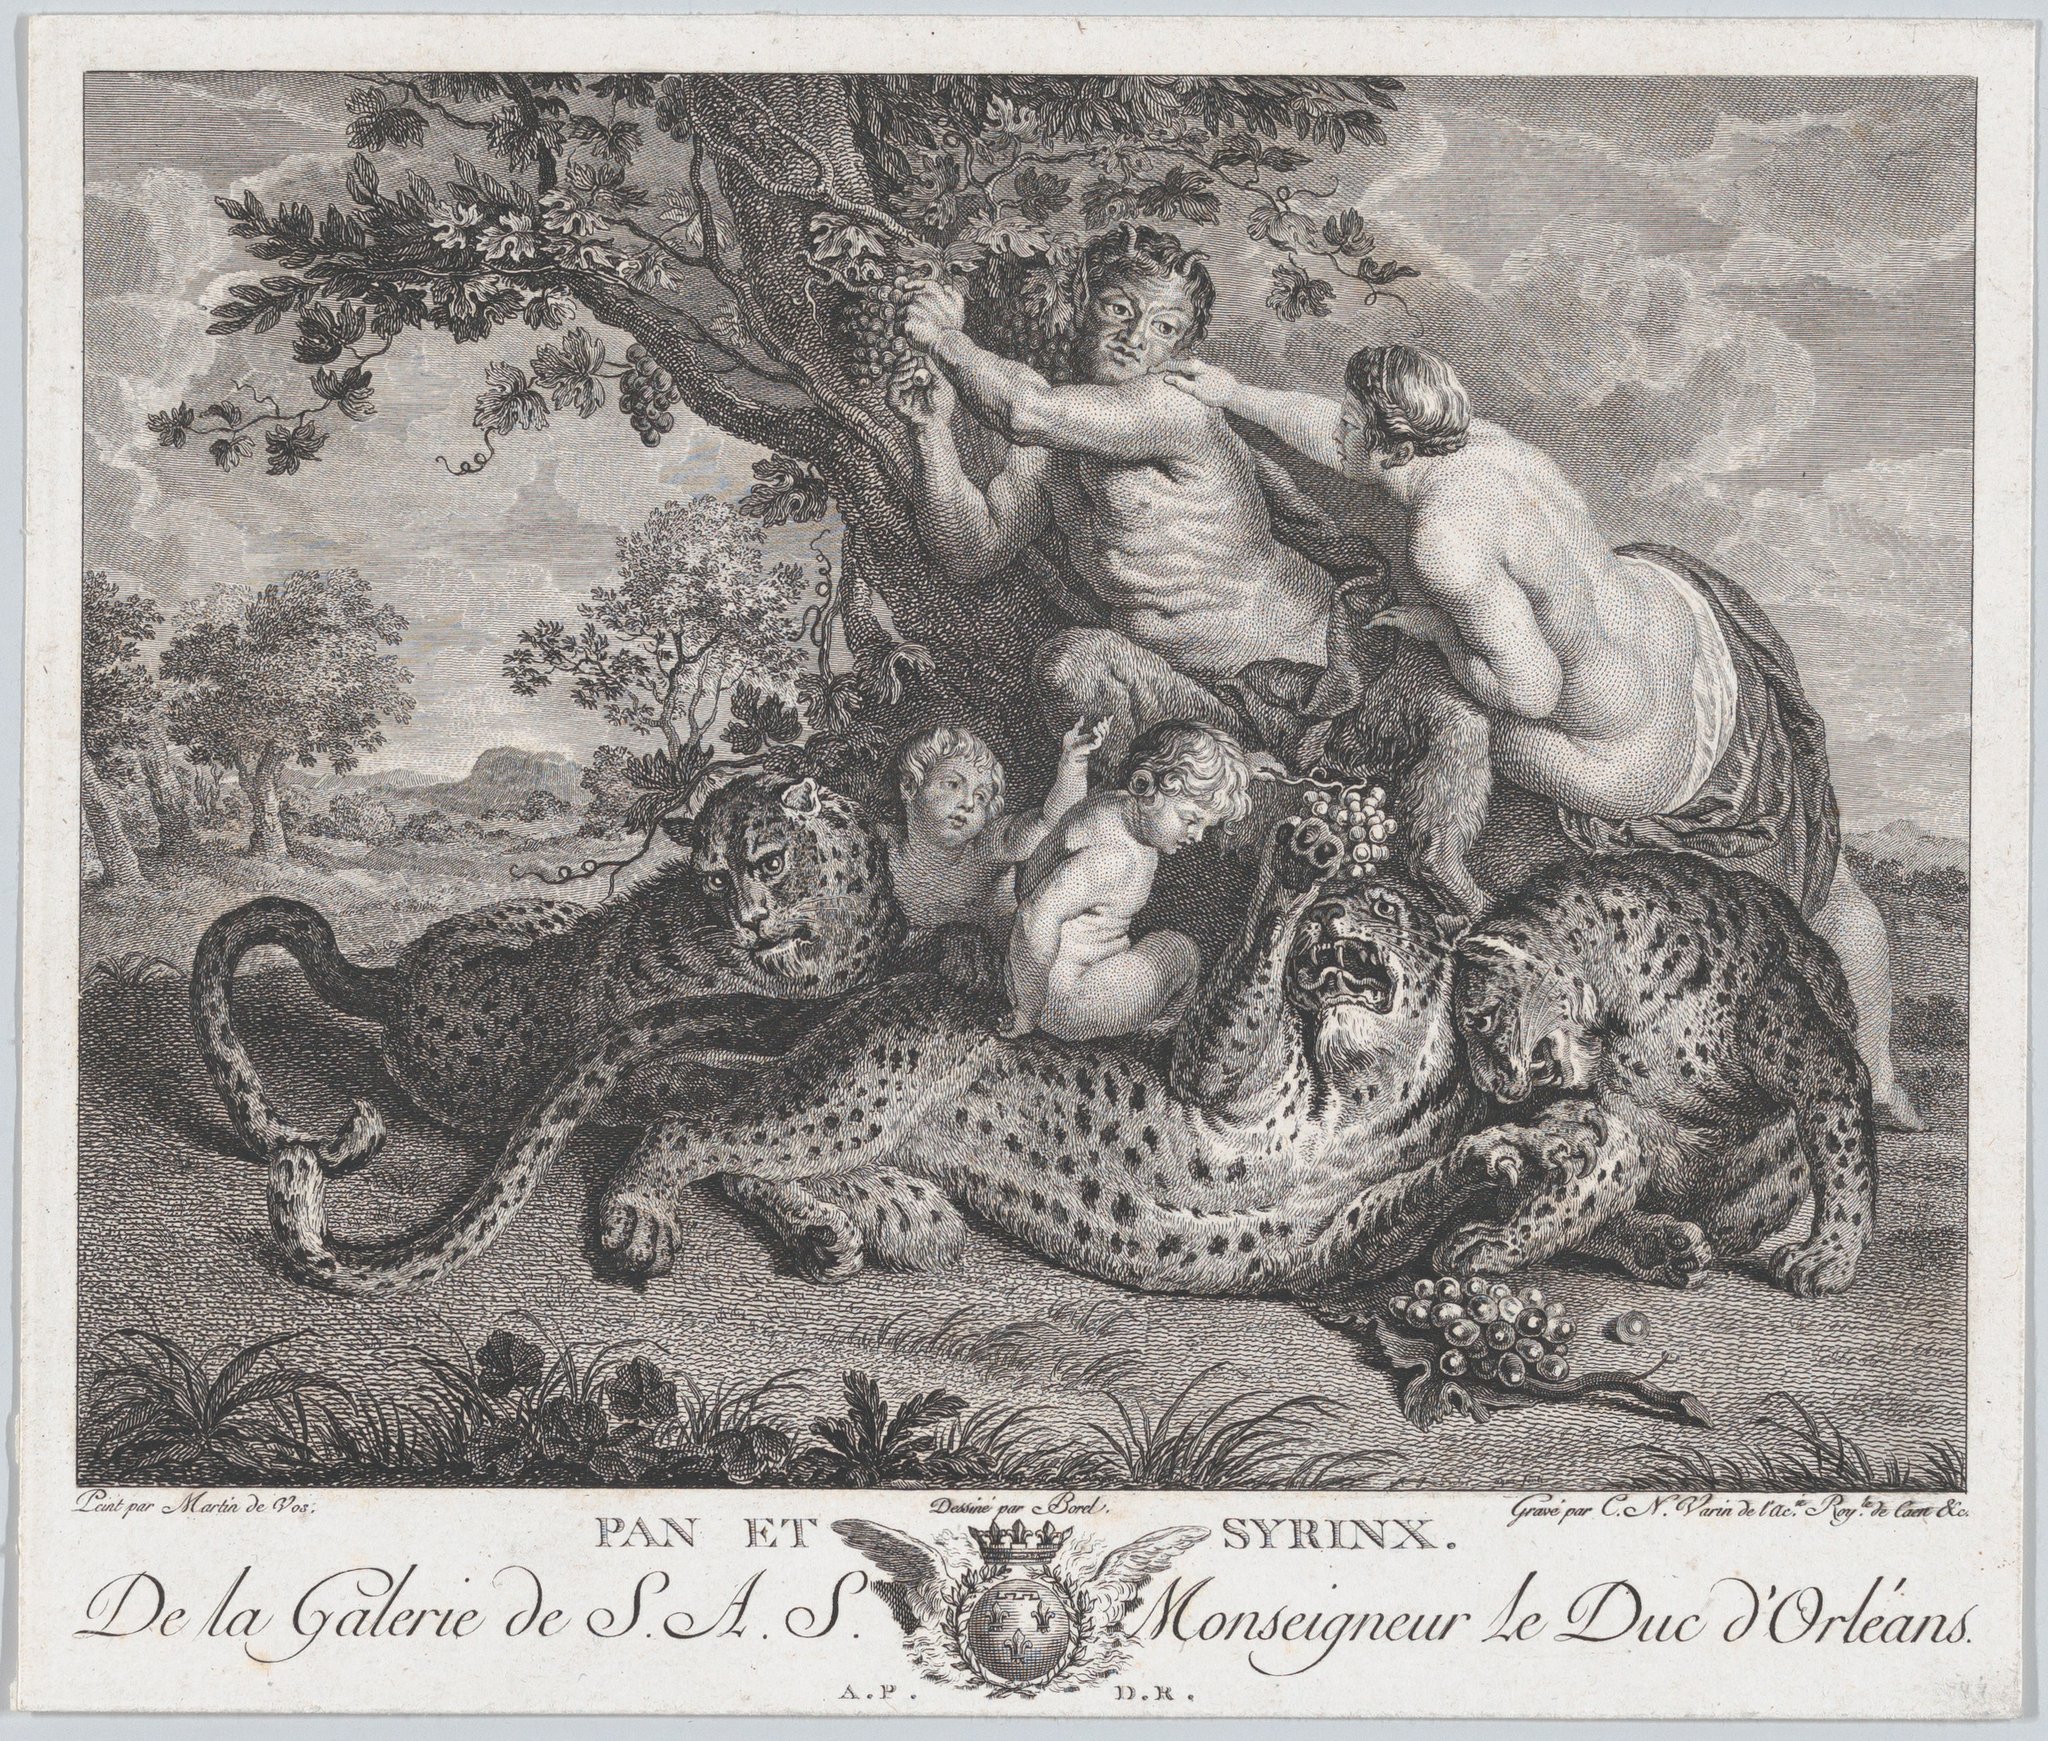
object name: print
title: Pan picking grapes while Syrinx grabs his shoulder, with three leopards and two putti below them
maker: charles nicolas varin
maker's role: artist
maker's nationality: french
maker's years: 1741-1812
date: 1787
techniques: engraving